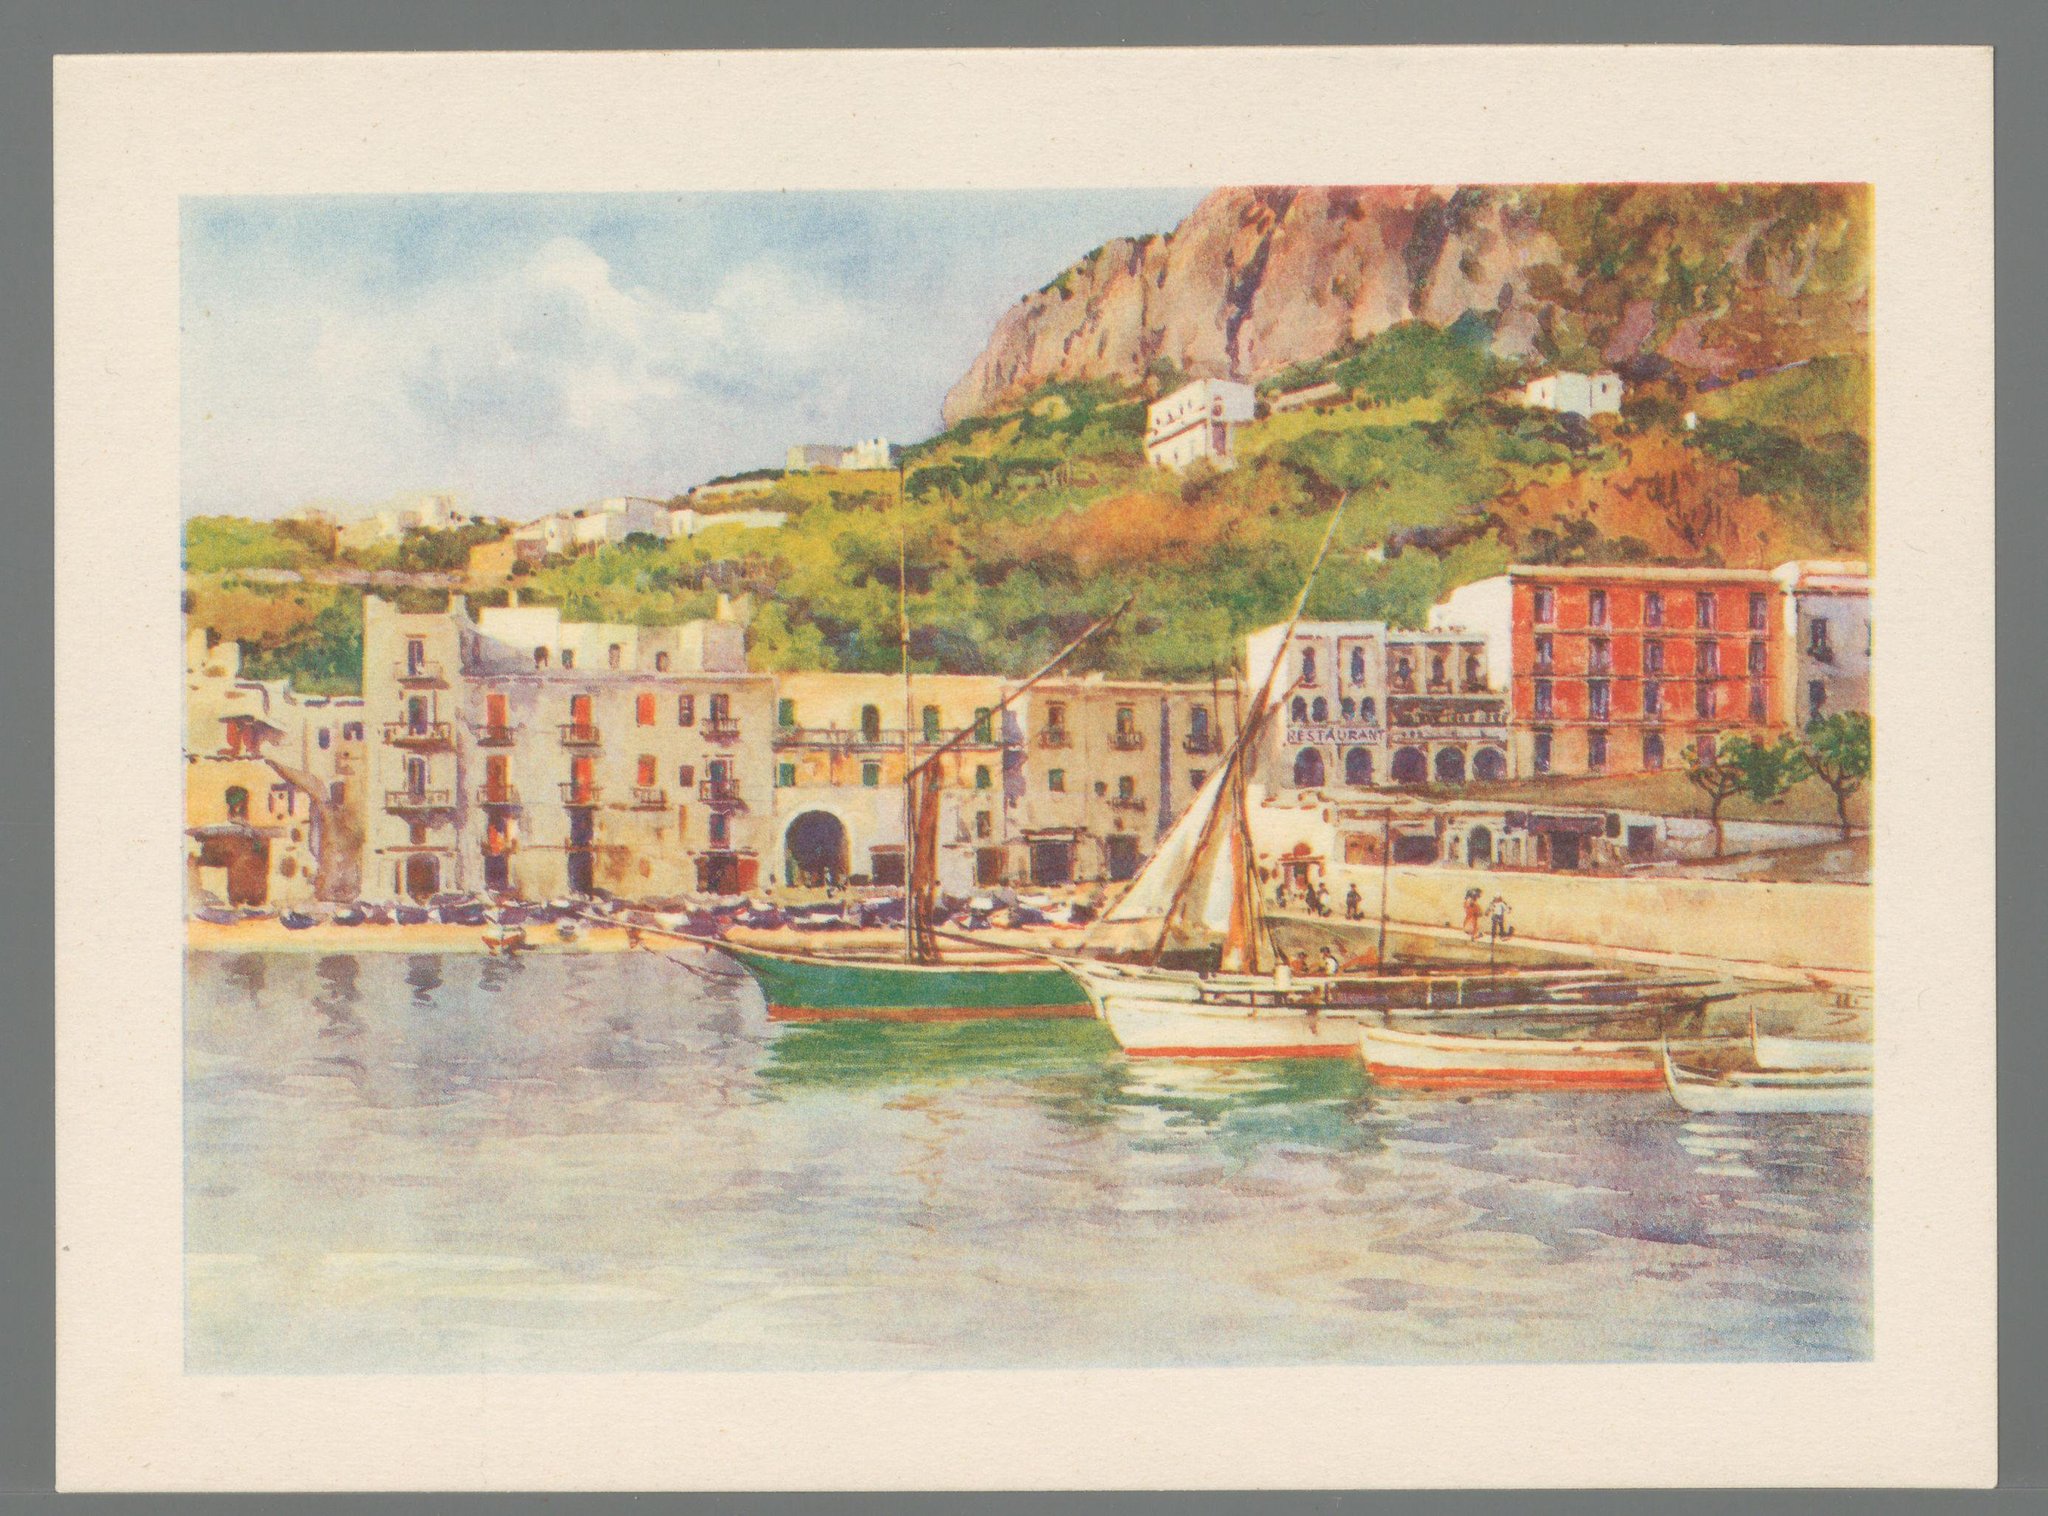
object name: photomechanical print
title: Capri. Marina grande. L'approdo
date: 1930-1960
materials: cardboard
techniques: photograph, lithograph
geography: italy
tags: harbour, prospect of city, town panorama, silhouette of city (+ city(-scape) with figures, staffage)